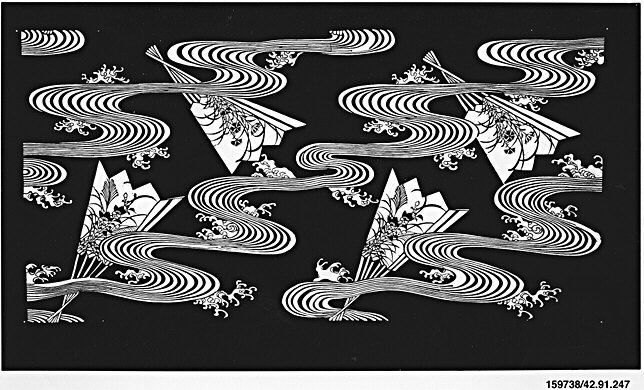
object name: stencil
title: Stencil with Pattern of Fans on Water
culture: japanese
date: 1801-1900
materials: paper, silk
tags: fans